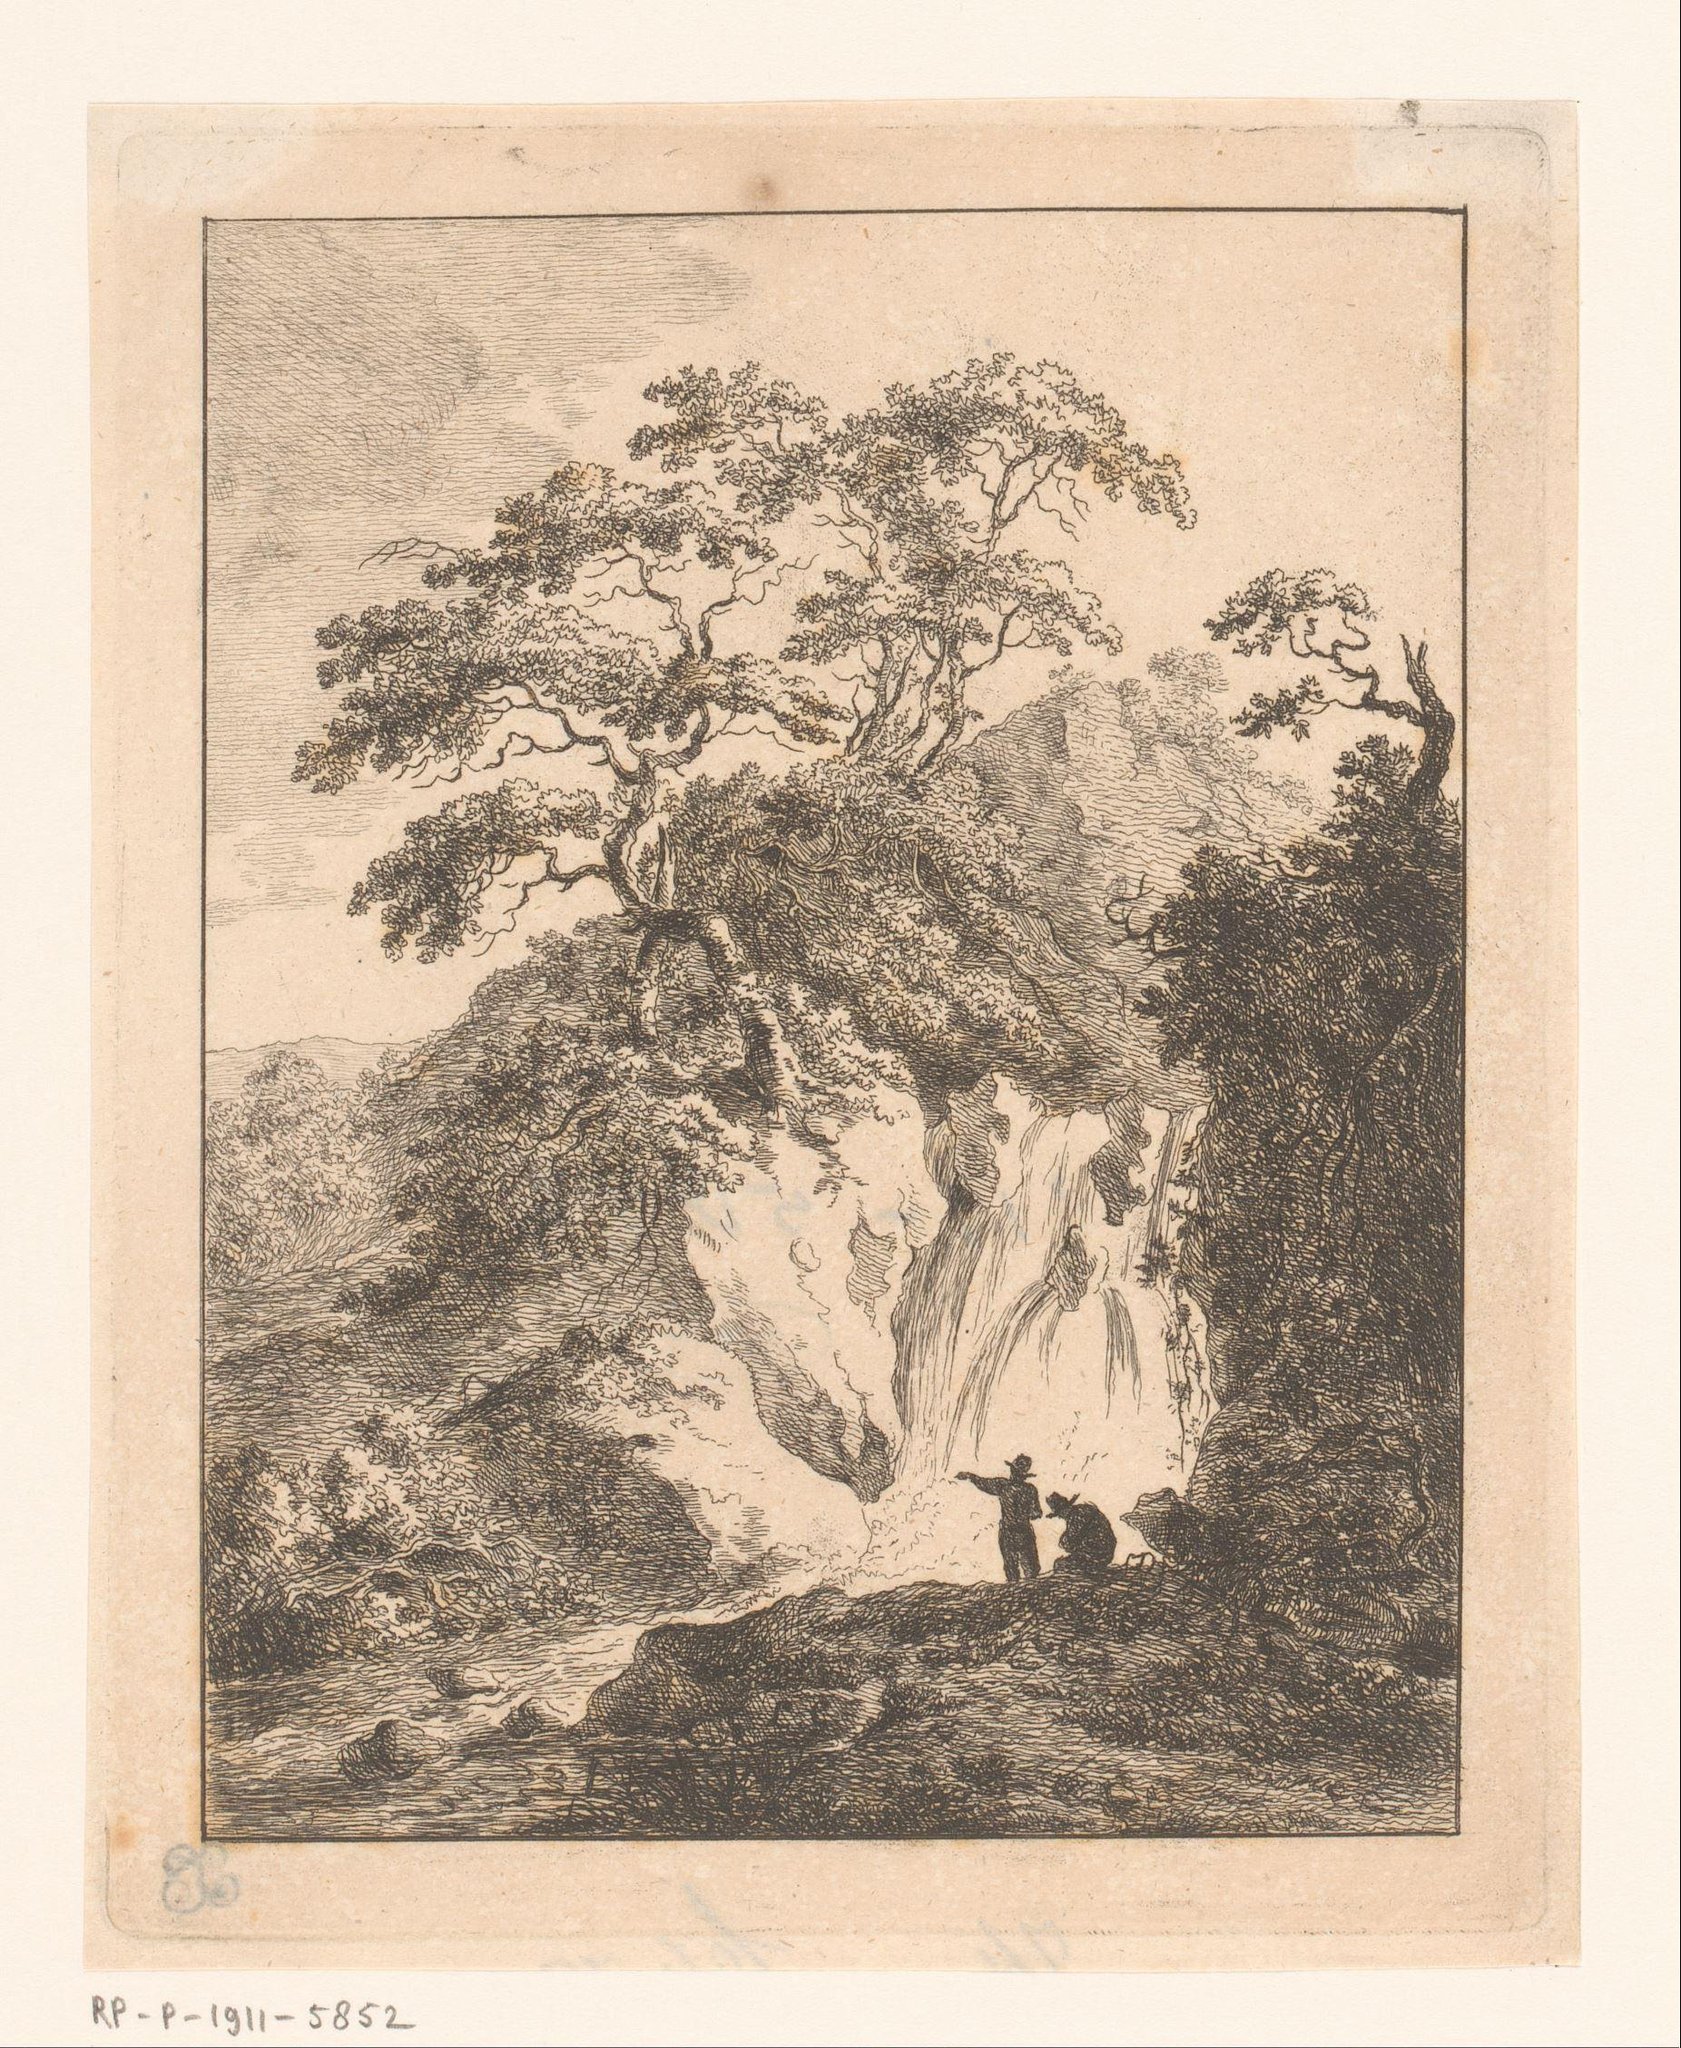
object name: print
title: Landschap met twee mannen bij een waterval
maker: sauveur legros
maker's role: print maker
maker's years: 1754-1834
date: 1764-1834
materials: paper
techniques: etching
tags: waterfall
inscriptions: collector's mark: Lugt 2228, collector's mark: Lugt 1485